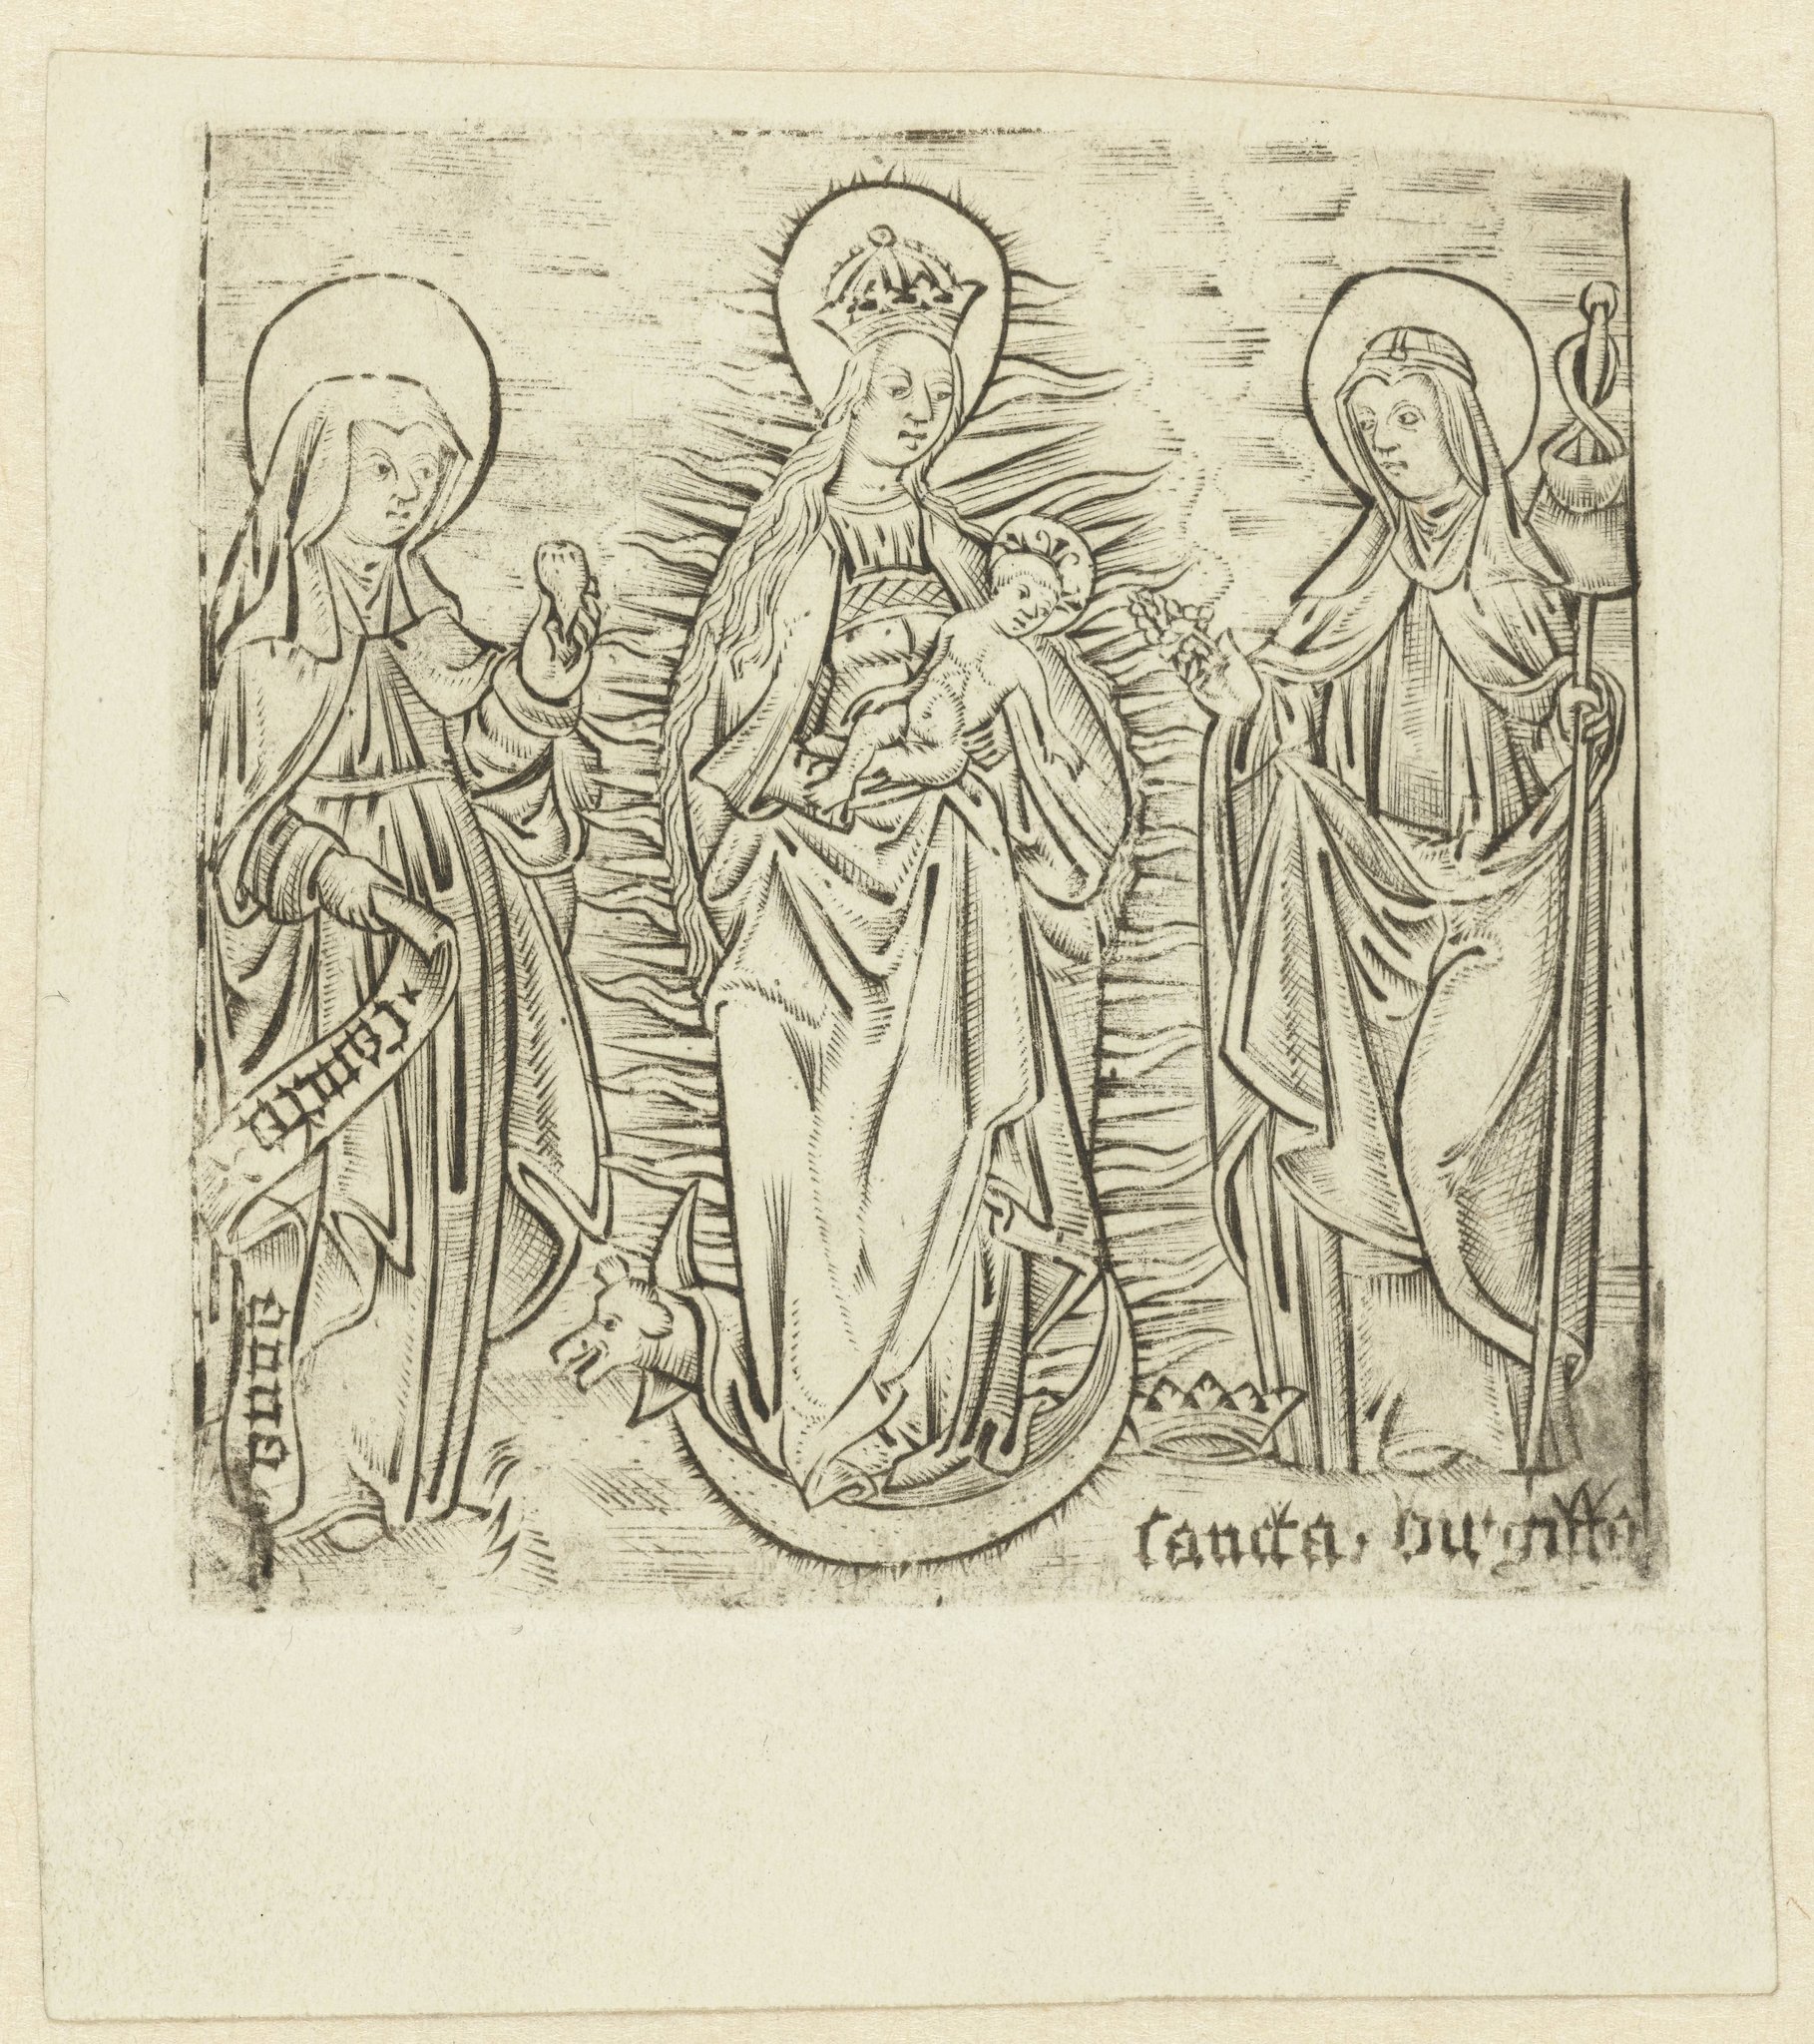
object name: print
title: Madonna met heilige Anna en Brigitta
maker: Anonymous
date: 1470-1490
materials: paper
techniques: engraving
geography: low countries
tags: mary standing (or half-length), the christ-child sitting on her arm (christ-child to mary's left), madonna on the crescent of the moon (sometimes called queen of heaven) (in mandorla), the foundress of the order of bri(d)gettines, the widow bridget (birgitta) of sweden; possible attributes: band over veil with five red spots, book, candle, heart with cross, inkhorn, pilgrim's hat, staff, wallet, anna, mother of mary; possible attributes: book, christ-child, lily, virgin mary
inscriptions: collector's mark: Lugt 2228a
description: De Maagd gekroond en op een maansikkel staande, het Christuskind in de armen. Aan haar rechterhand de heilige Anna, aan haar linkerhand de heilige Brigitta.